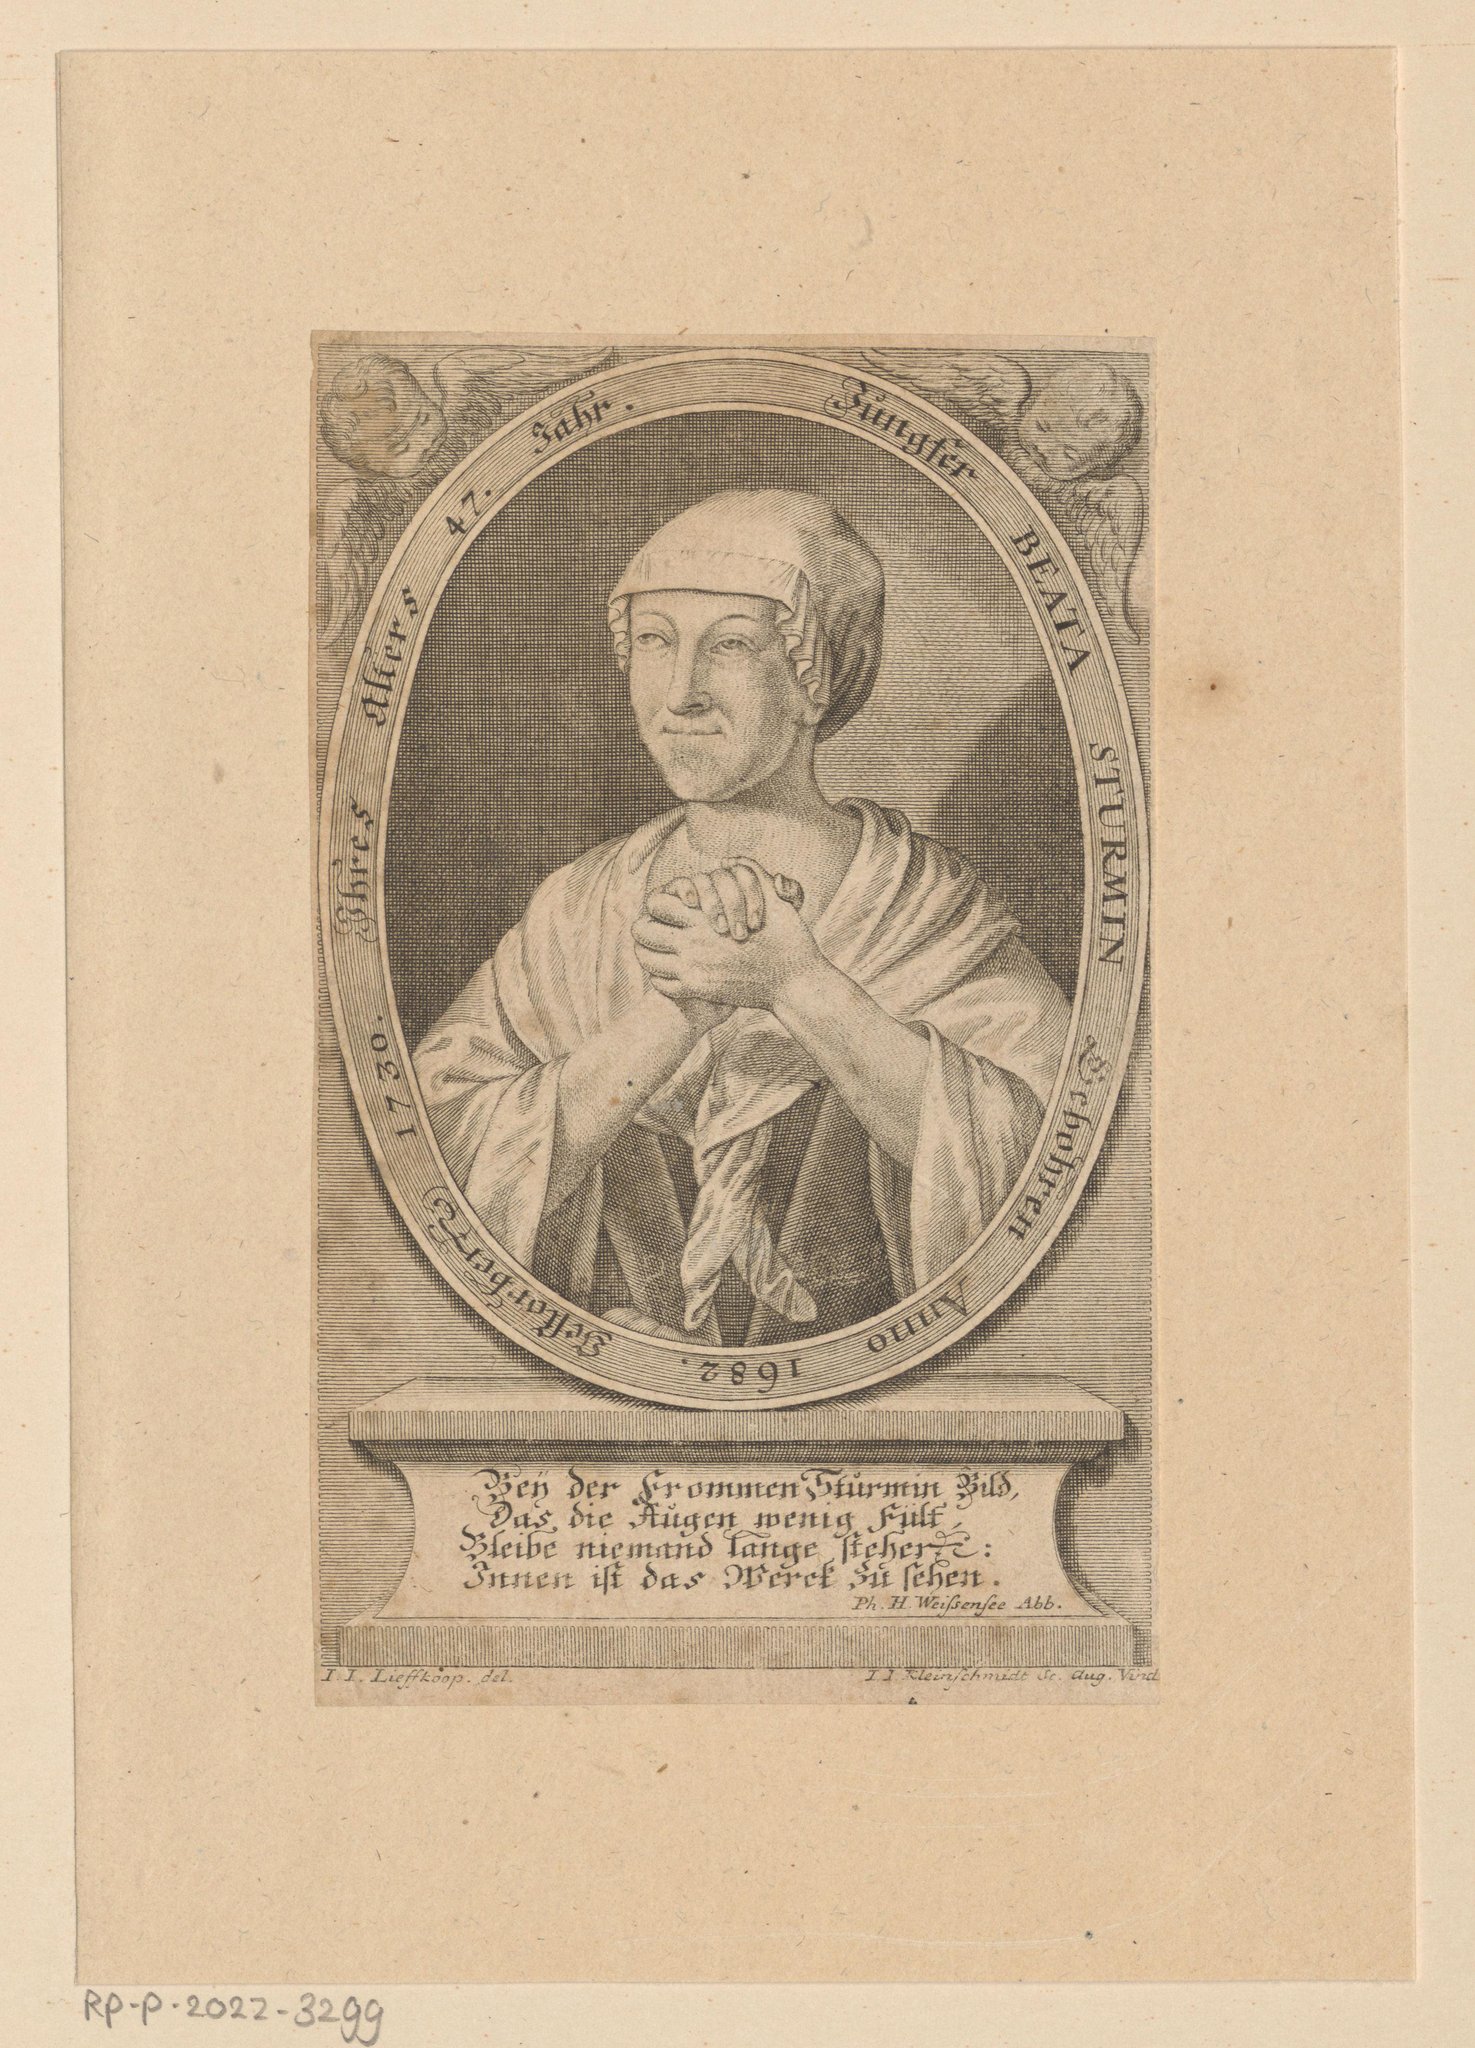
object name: print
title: Portret van Beata Sturm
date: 1730-1767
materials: paper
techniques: engraving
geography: augsburg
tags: historical persons - bb - woman, nun(s), philantropist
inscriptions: collector's mark: Lugt 2233